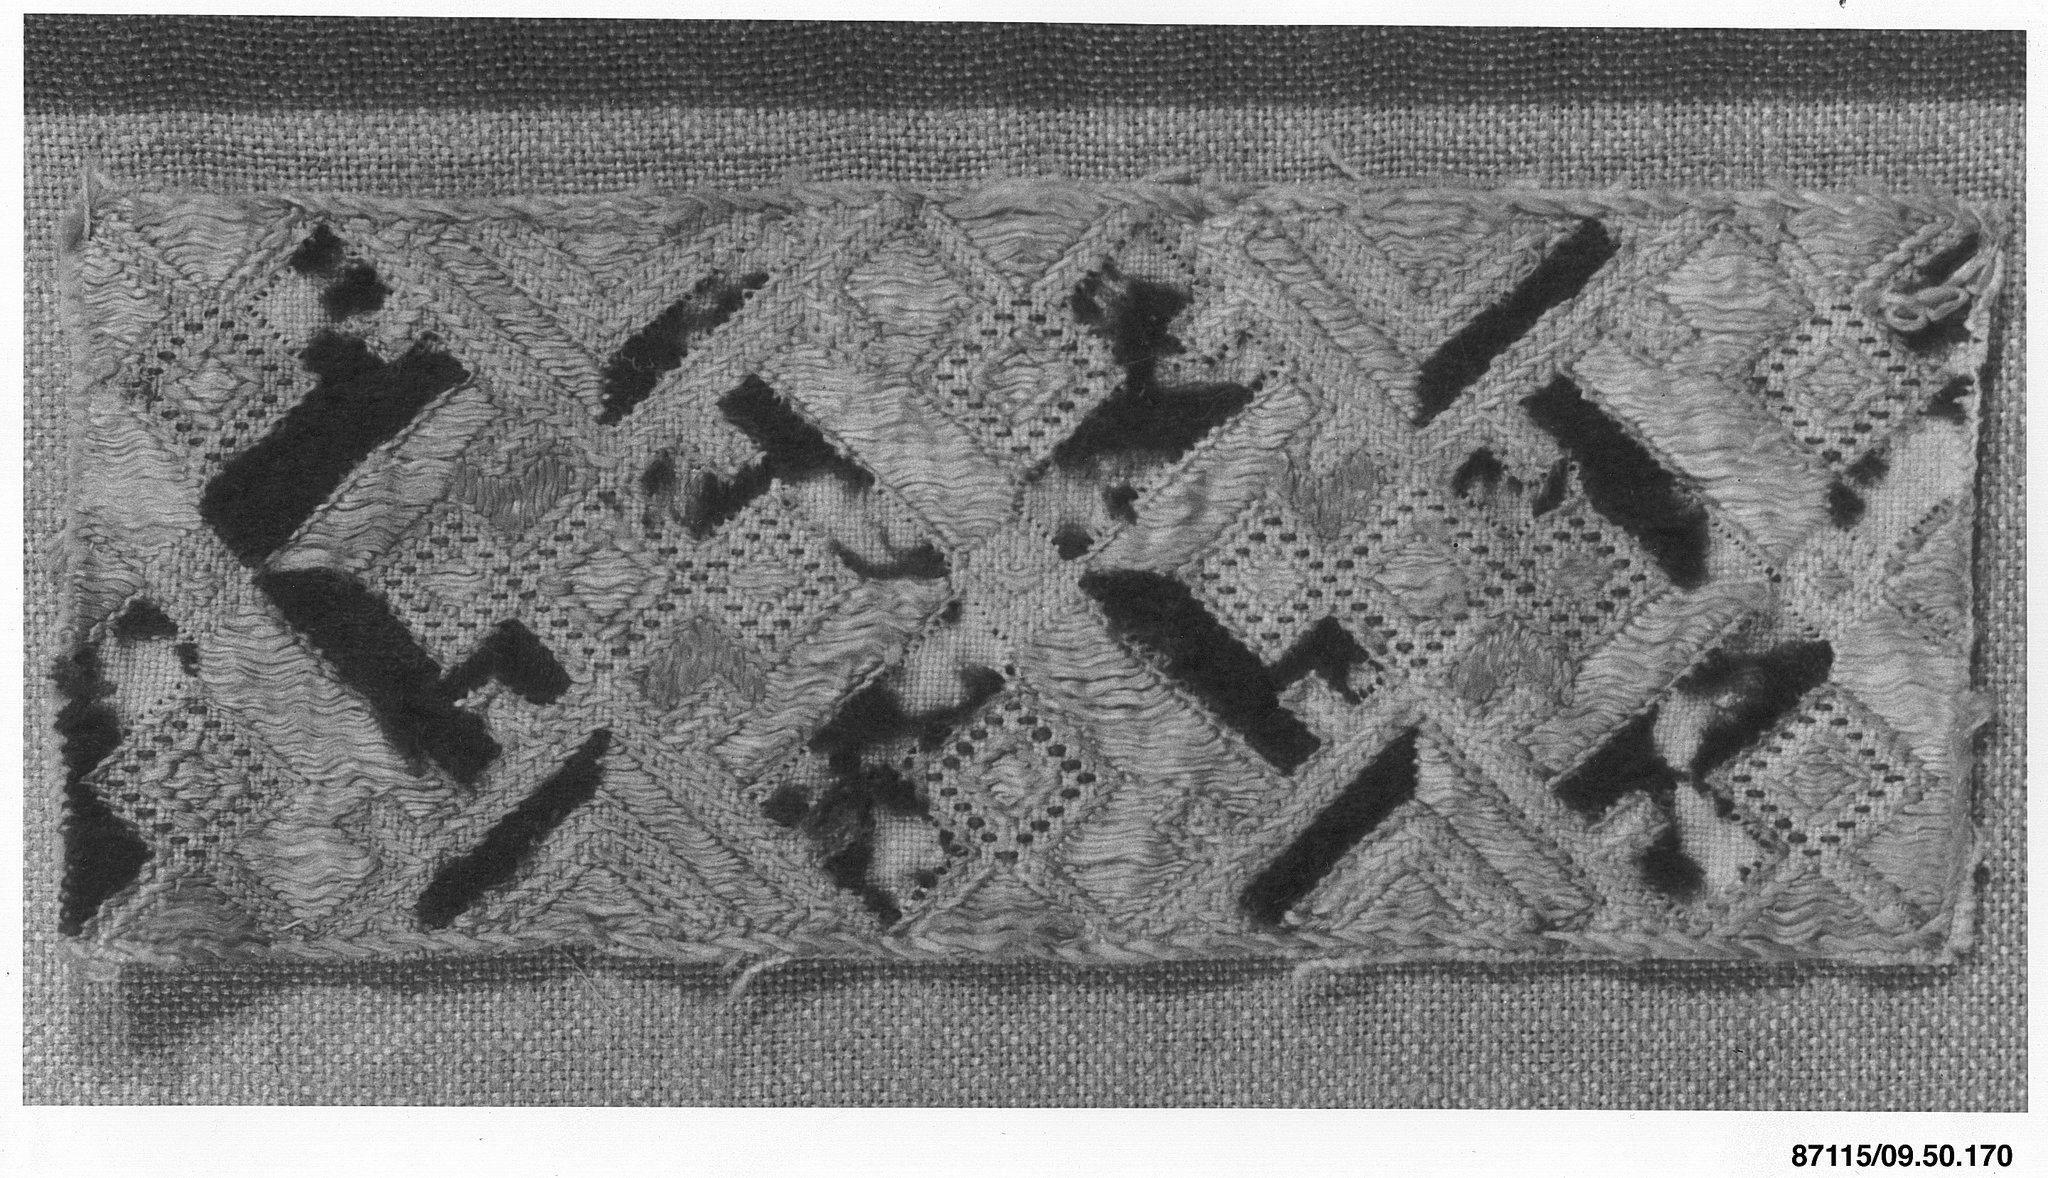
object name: costume fragment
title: Peasant costume fragment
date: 1701-1900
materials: linen, silk